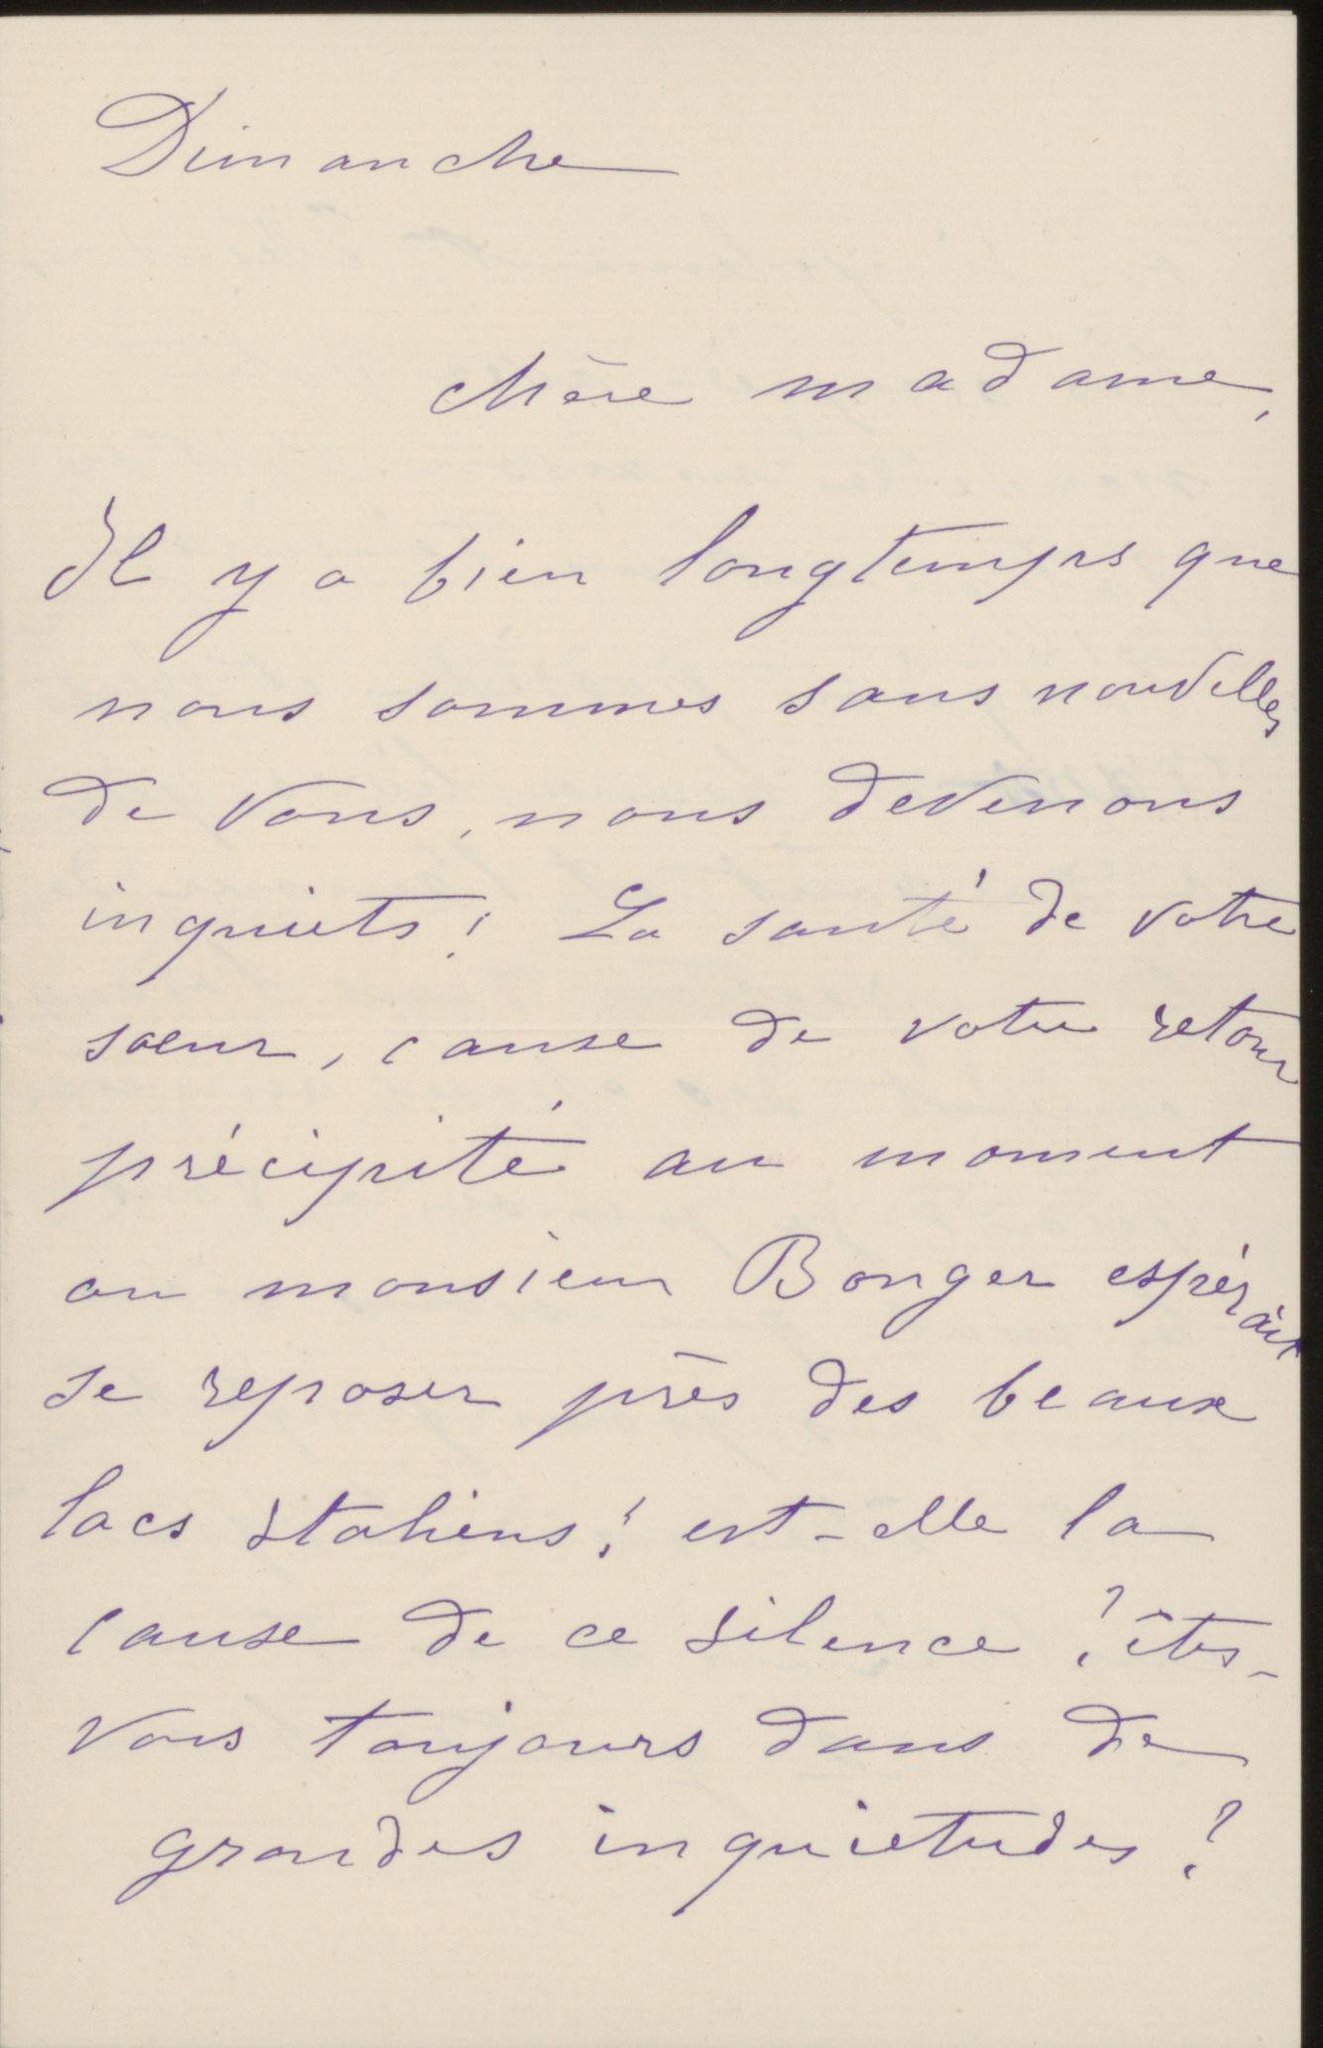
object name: letter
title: Brief aan Anne Marie Louise van der Linden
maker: camille redon-falte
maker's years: 1853-1923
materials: ink, paper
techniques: pen, writing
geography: paris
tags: paris, painter, print maker, draughtsman, odilon redon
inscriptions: watermark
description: Brief behoort tot een album samengesteld door weduwe Françoise W.M. Barones van der Borch van Verwolde met afschriften van brieven met betrekking tot (de familie van) Odilon Redon. De brief werd bewaard op pagina 121.